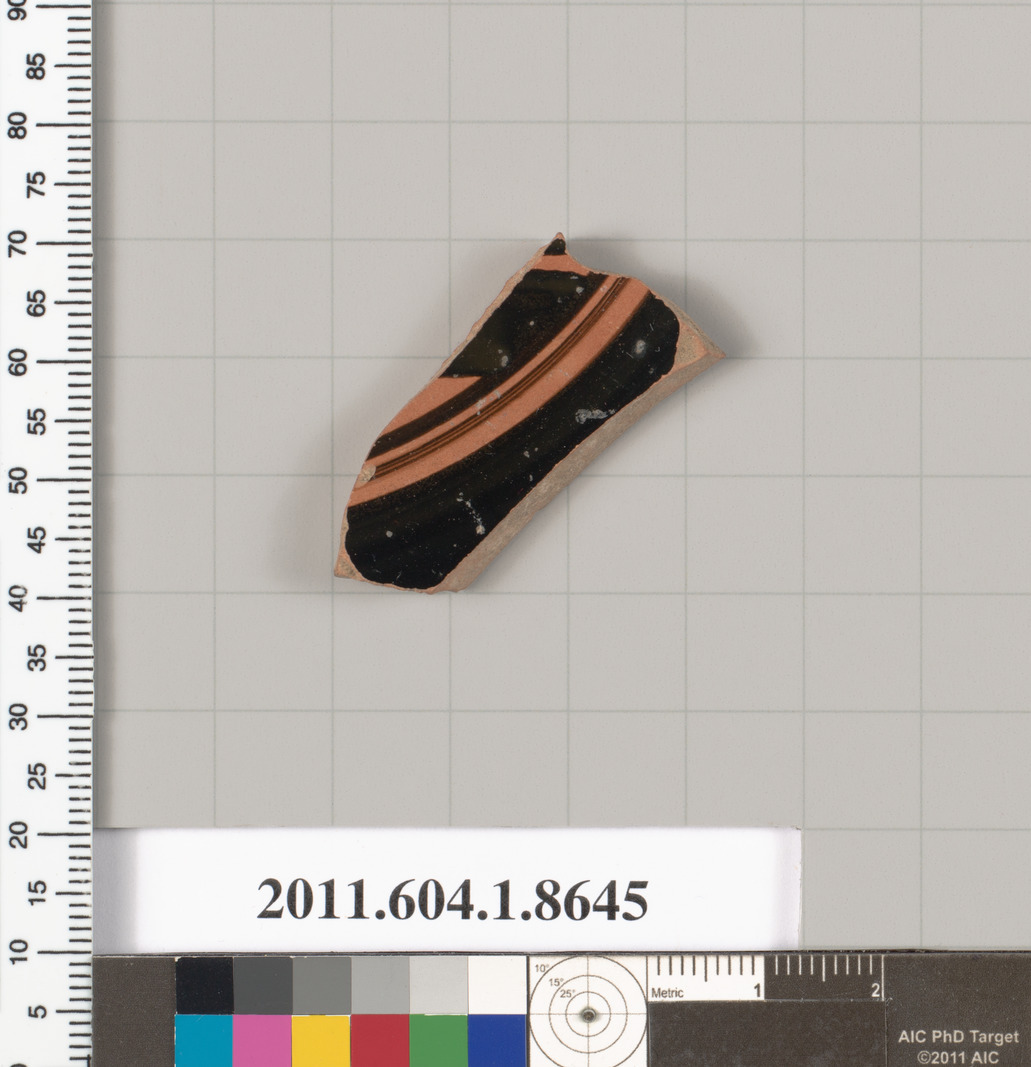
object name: kylix fragment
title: Terracotta fragment of a stemless kylix (drinking cup)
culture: greek, attic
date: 460-450 BCE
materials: terracotta